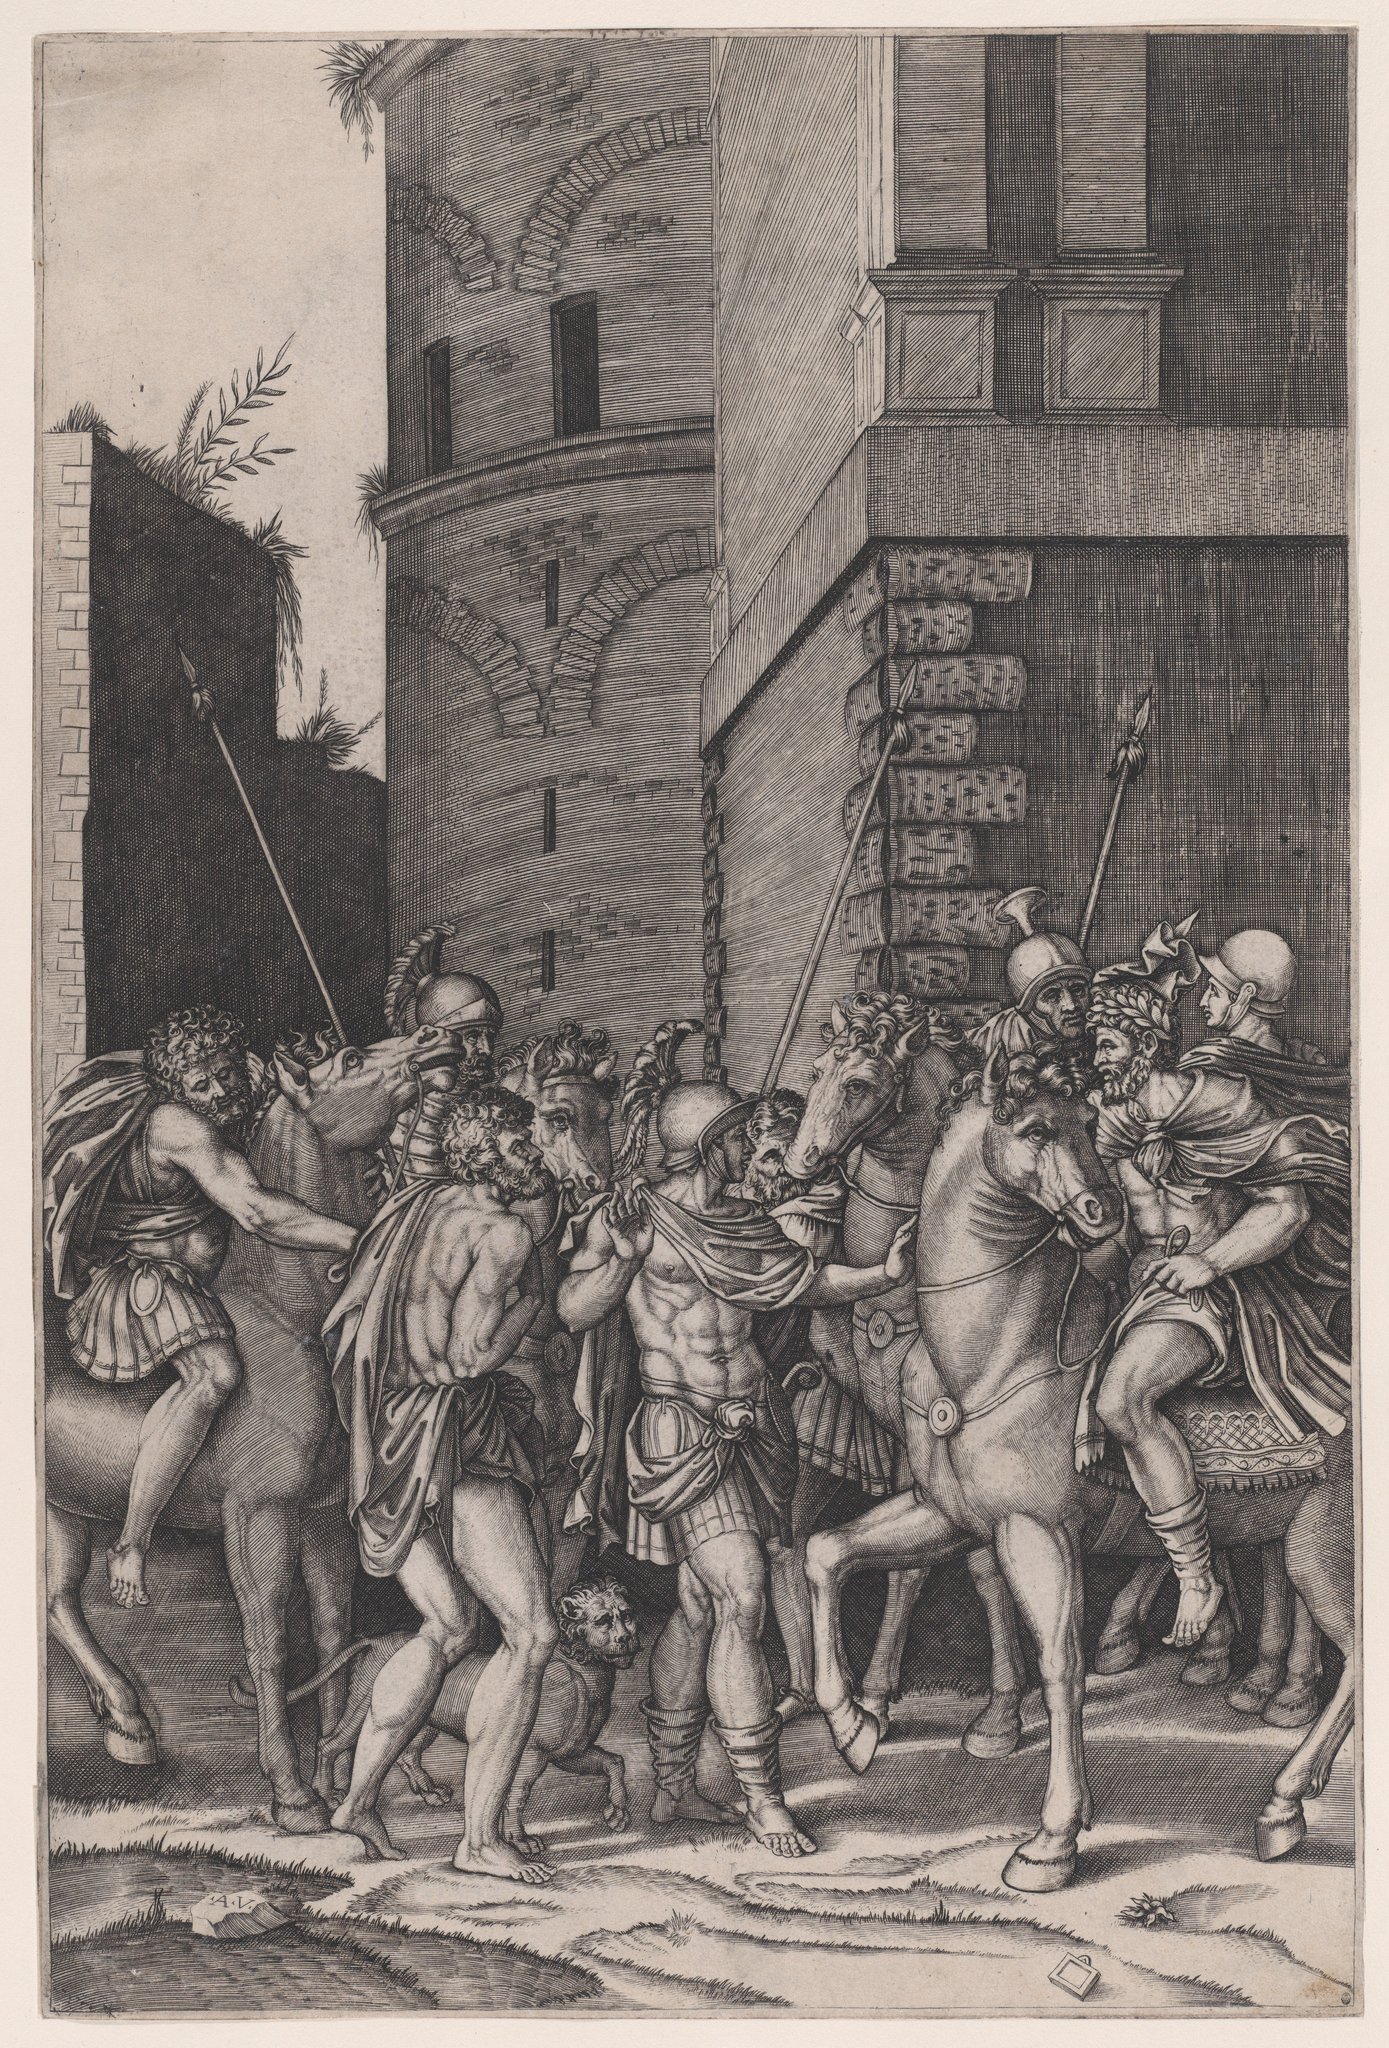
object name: print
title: The Emperor Meeting the Warrior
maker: agostino veneziano (agostino dei musi)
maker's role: artist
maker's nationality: italian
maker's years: 1490-1536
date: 1516-1517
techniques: engraving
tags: emperors,men,horses